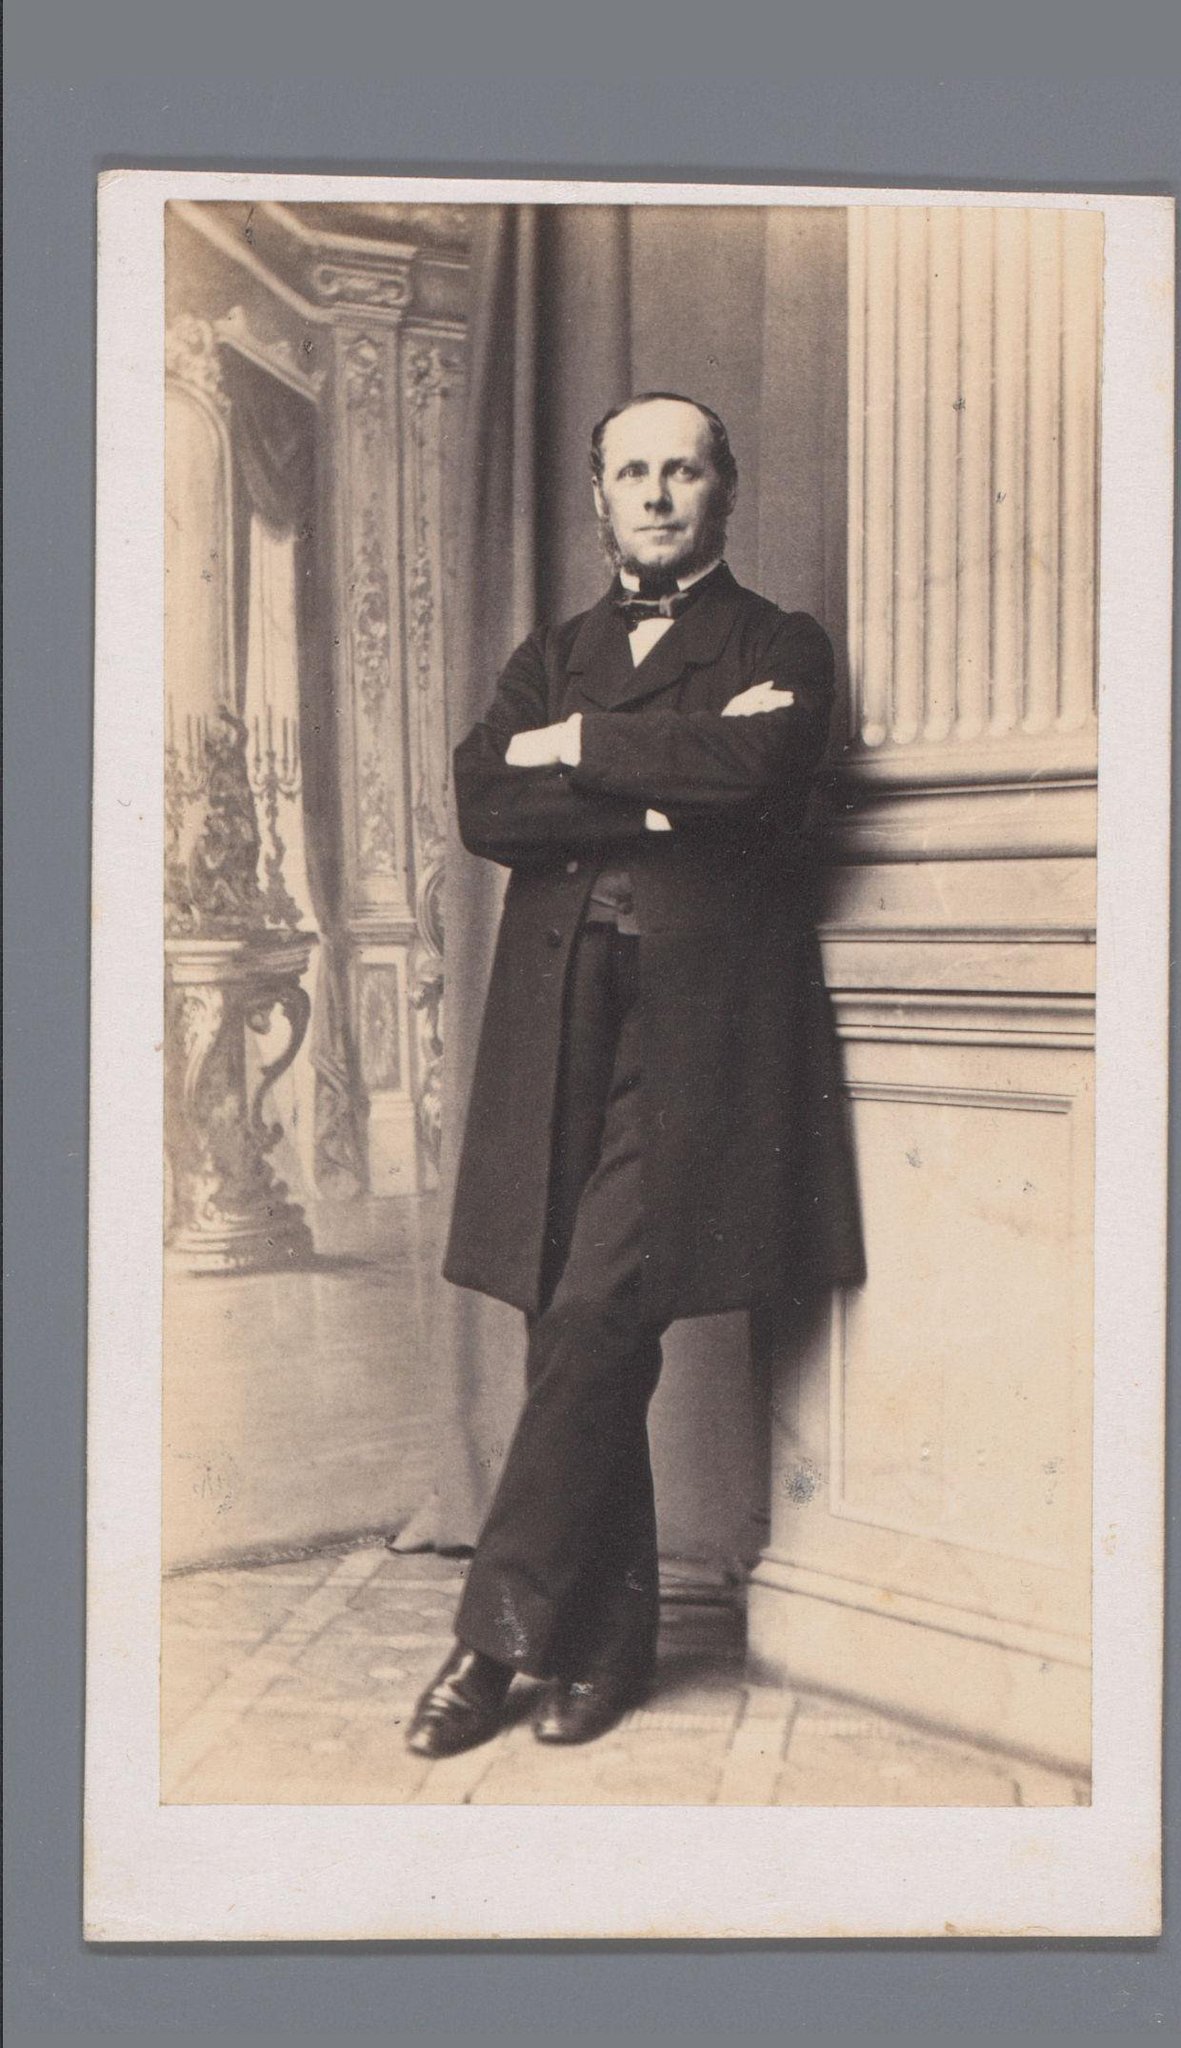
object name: carte de visite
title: Portret van een onbekende staande man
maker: gustav schauer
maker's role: painter, publisher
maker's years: 1826-1902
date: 1851-1864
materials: cardboard, paper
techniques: albumen print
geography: berlin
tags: adult man, anonymous historical person portrayed, berlin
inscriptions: inscription: ‘Gustav Schauer/ Photographische Kunst- und Verlags-Institut/ Berlin/ Grosse Friedrichs-Strasse/ No. 188.’